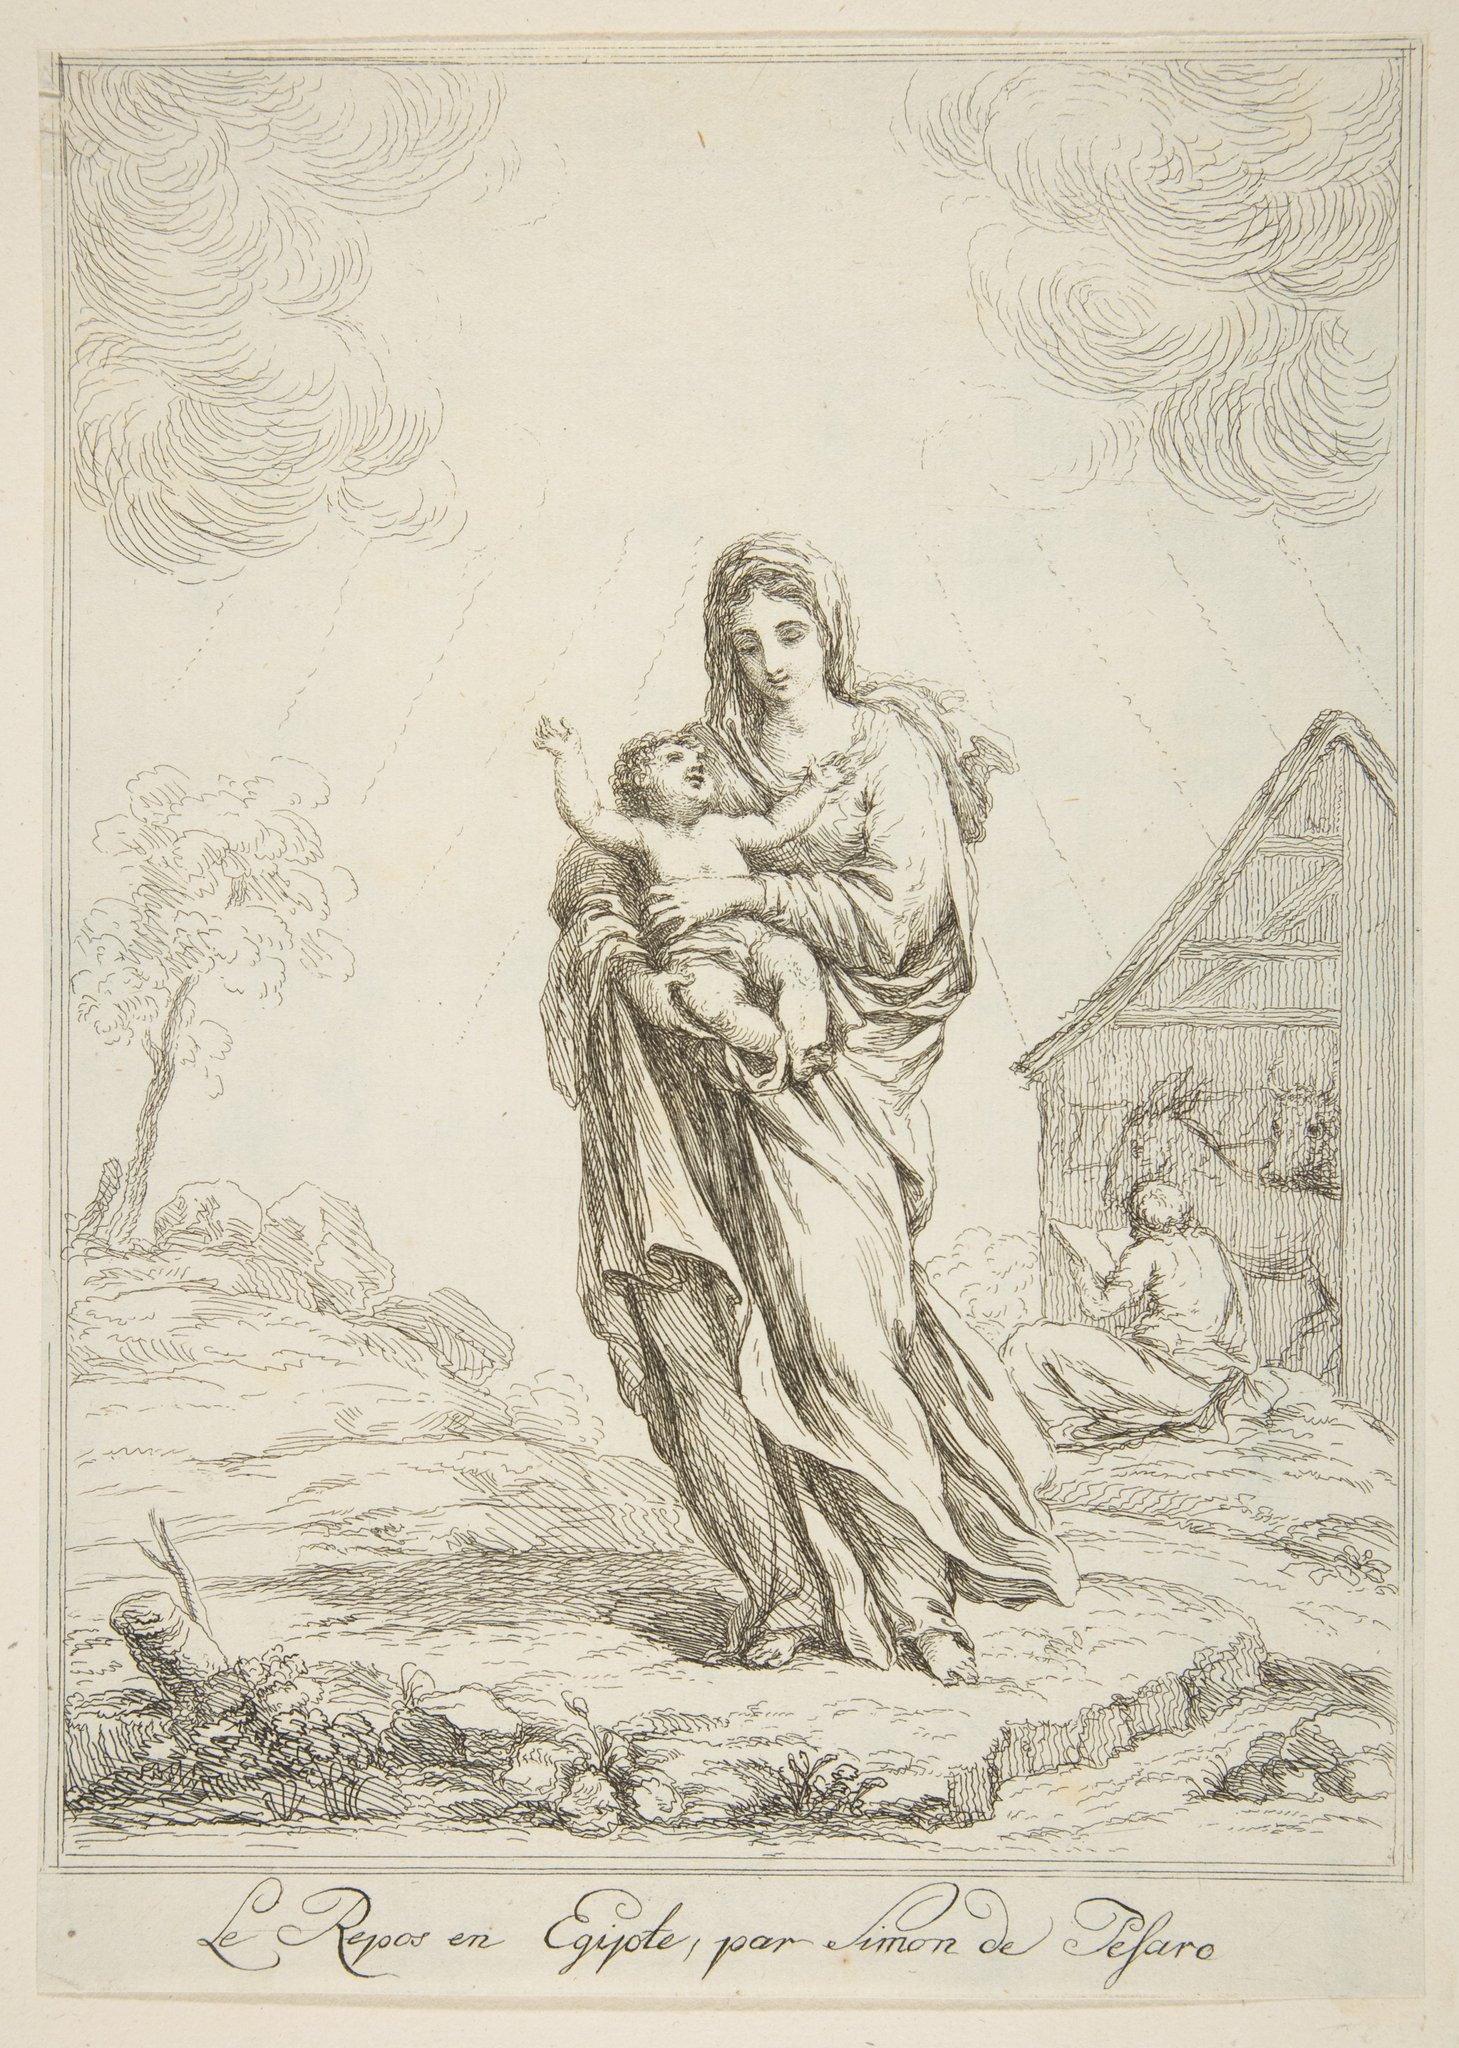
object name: print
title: Rest on the flight into Egypt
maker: anonymous, french, 18th century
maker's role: artist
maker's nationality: french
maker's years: 1700-1800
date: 1701-1800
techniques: etching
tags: madonna and child